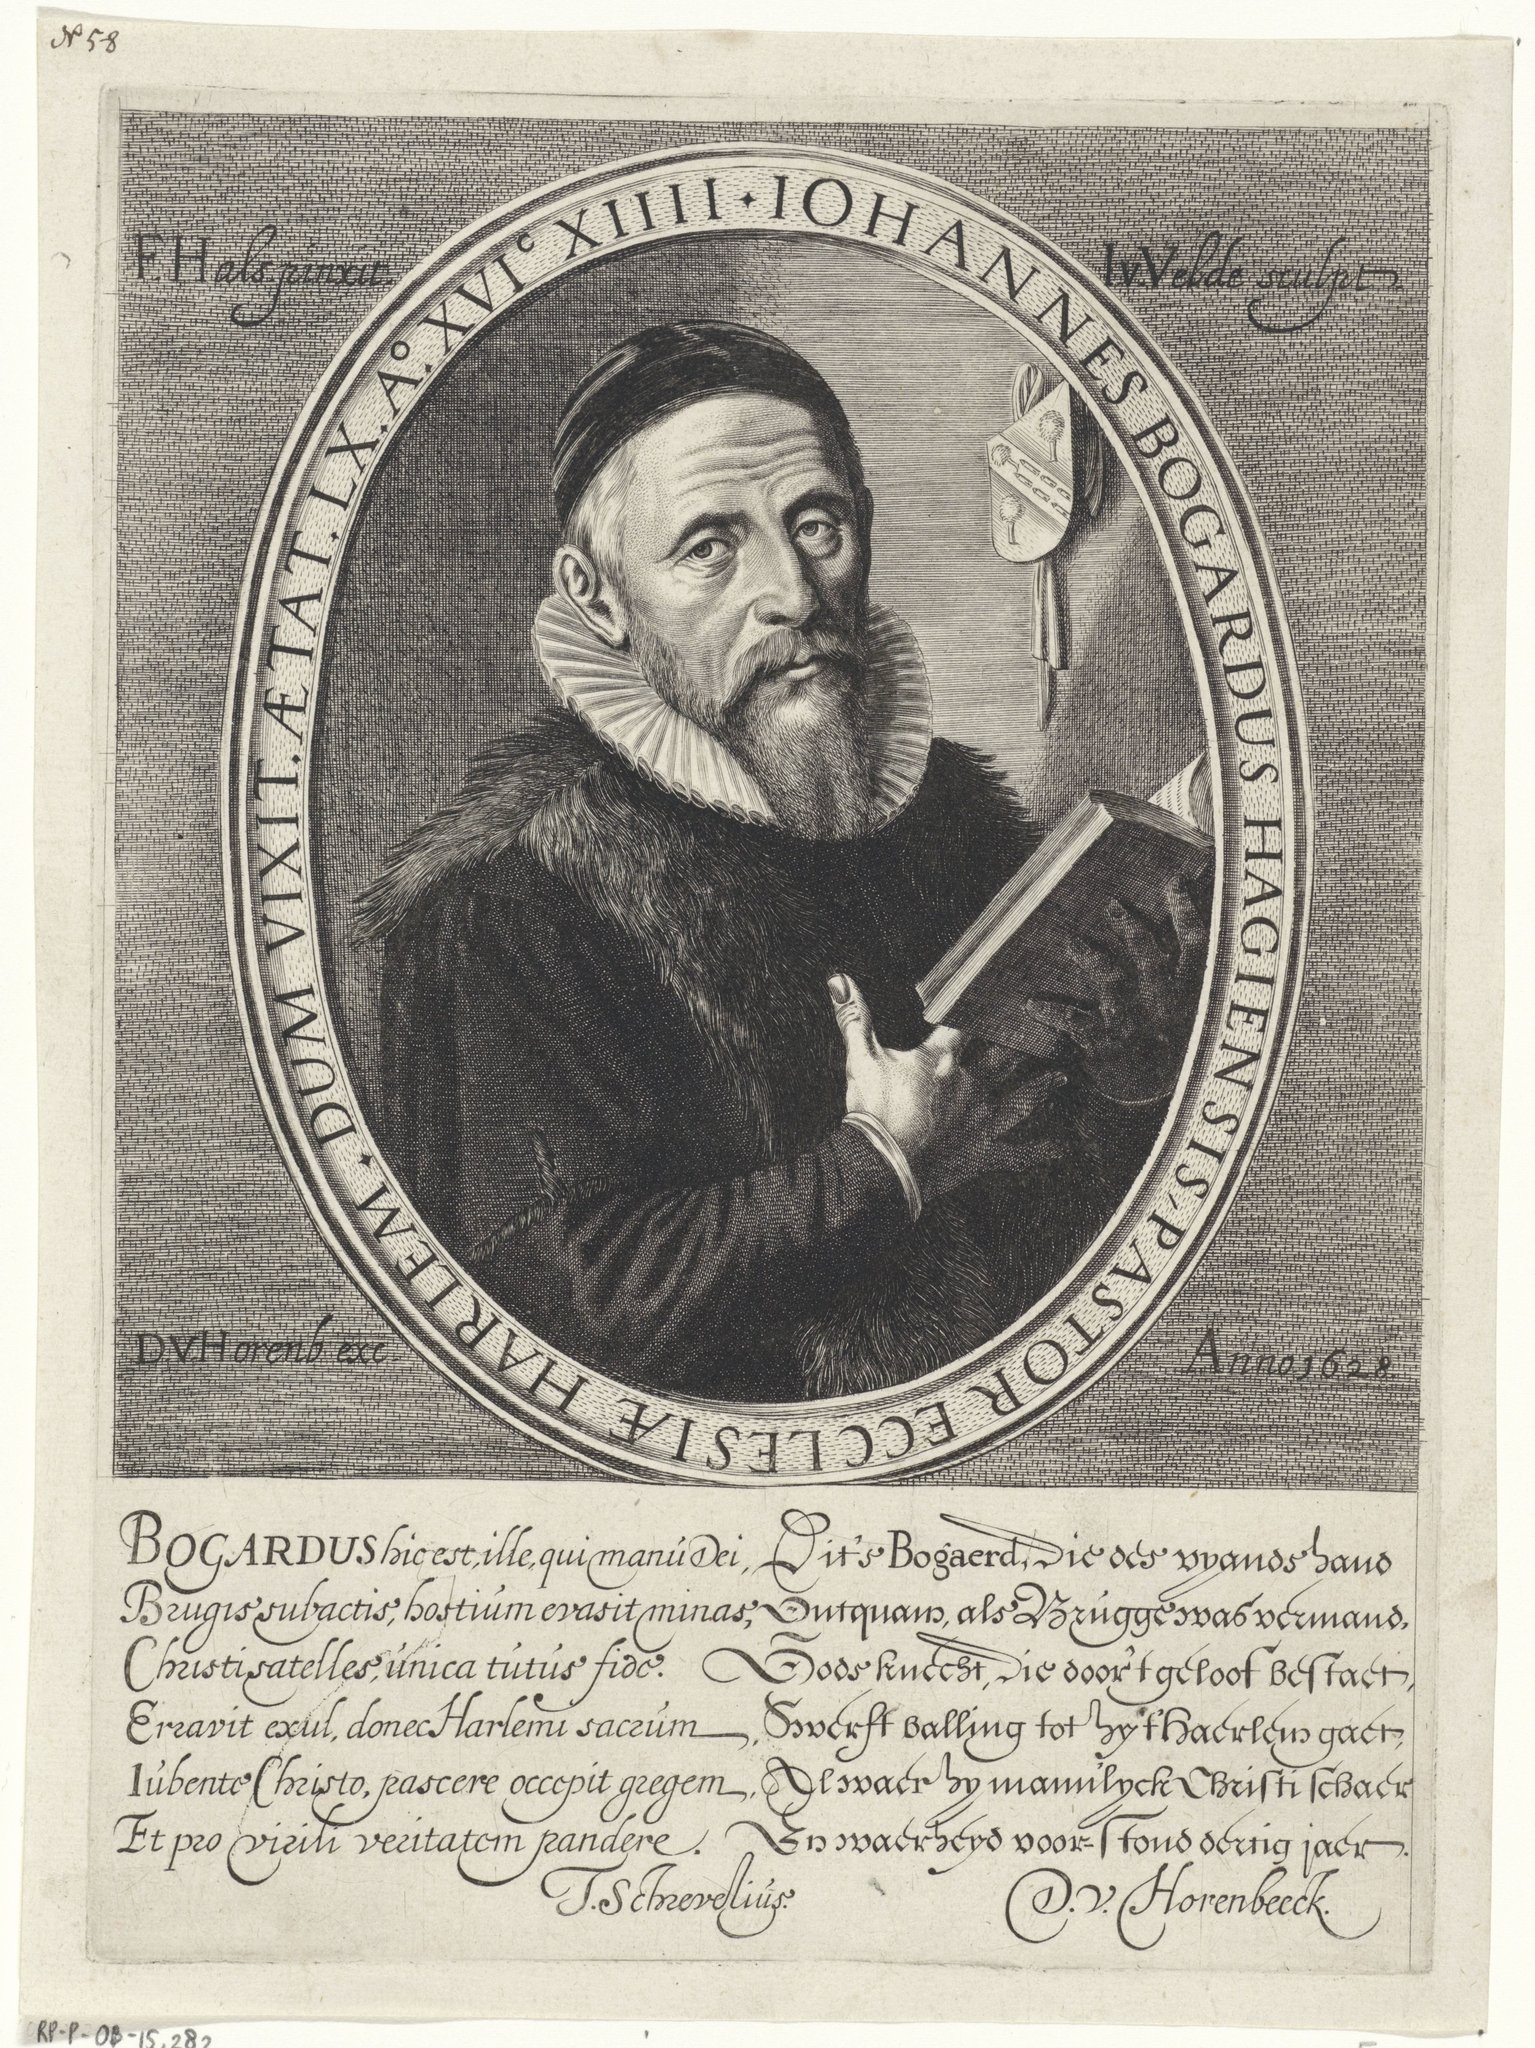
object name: print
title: Portret van Johannes Bogaert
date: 1628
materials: paper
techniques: engraving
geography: northern netherlands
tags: johannes bogaert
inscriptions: collector's mark: Lugt 240, number: ‘No. 58’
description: Portret van Johannes Bogaert, predikant te Haarlem.